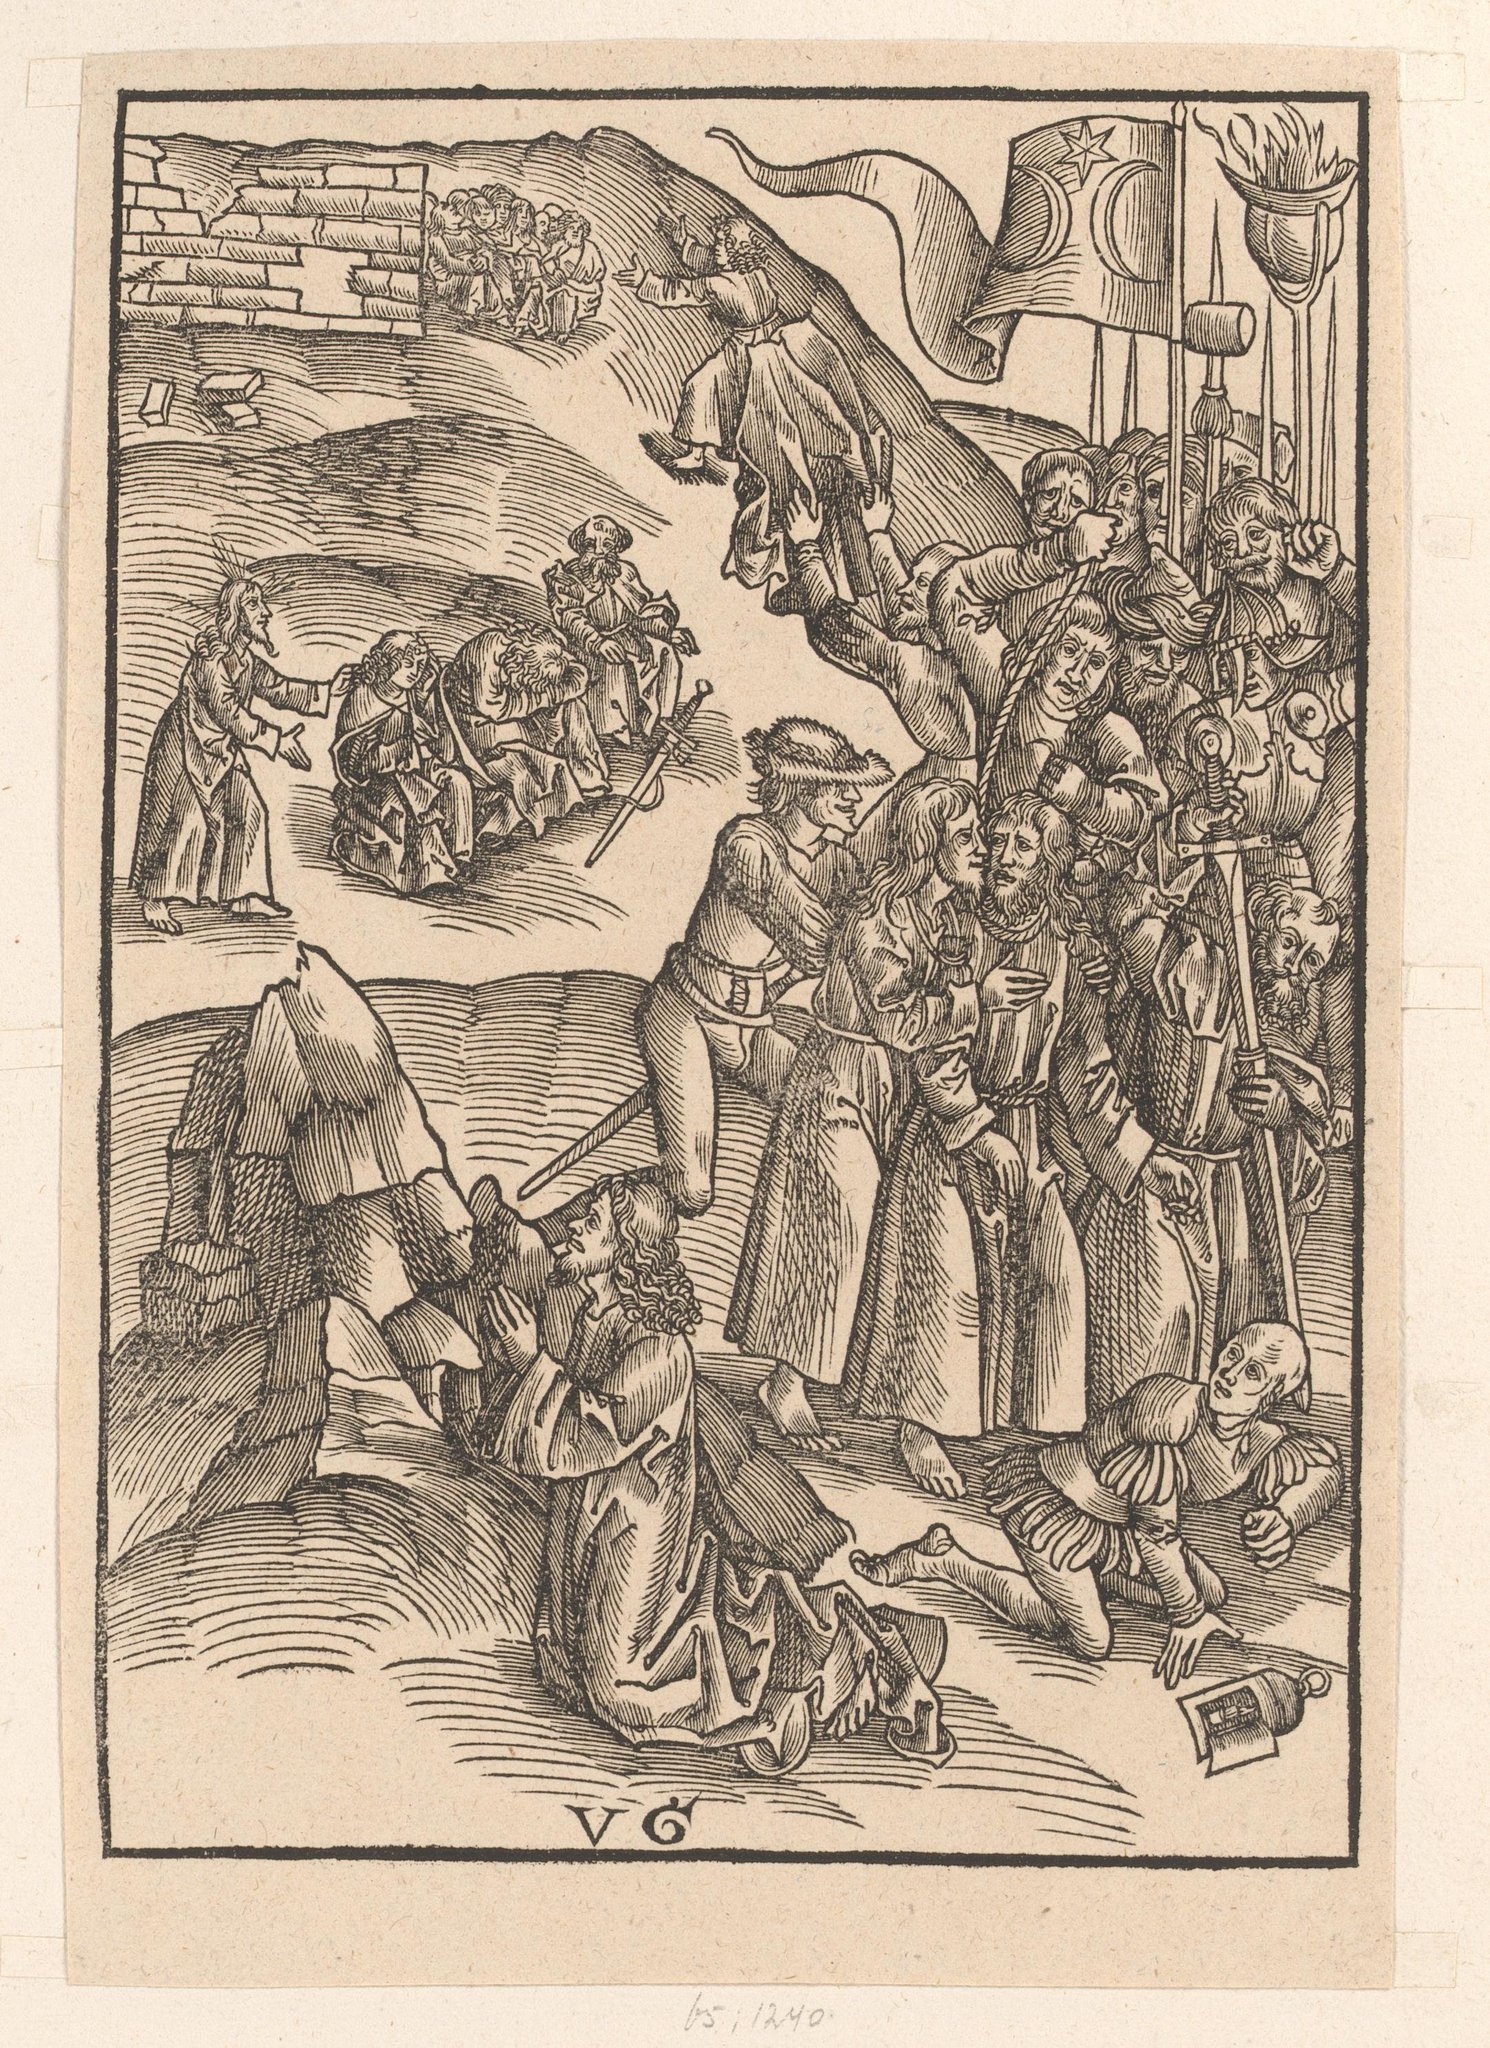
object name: album leaf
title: Christus in de hof van Getsemane en gevangenneming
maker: urs graf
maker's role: draughtsman, print maker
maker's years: 1485-1528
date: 1506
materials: paper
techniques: woodcut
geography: switzerland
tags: agony of christ; three (or eleven) apostles sleeping, one of the fleeing disciples of christ is nearly seized, but makes good his escape half dressed, or naked, peter draws his sword and cuts off malchus' ear, the kiss of judas: accompanied by soldiers with torches and lanterns, he kisses christ, christ's prayer in the garden of gethsemane during the night, malchus is healed by christ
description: Christus bidt geknield op de voorgrond. Linksmidden treft hij zijn drie leerlingen, die hij had gevraagd met hem te waken, slapend aan. Rechts de gevangenneming van Christus. Judas kust hem op de wang. Petrus heeft het oor van Malchus afgeslagen en doet zijn zwaard terug in de schede. Christus houdt het oor van Malchus in de hand om het weer aan Malchus hoofd te zetten en te genezen. Op de achtergrond één van de leerlingen die op de vlucht slaat. Zijn kleed blijft achter in de handen van een van de soldaten. Prent maakt deel uit van een album.